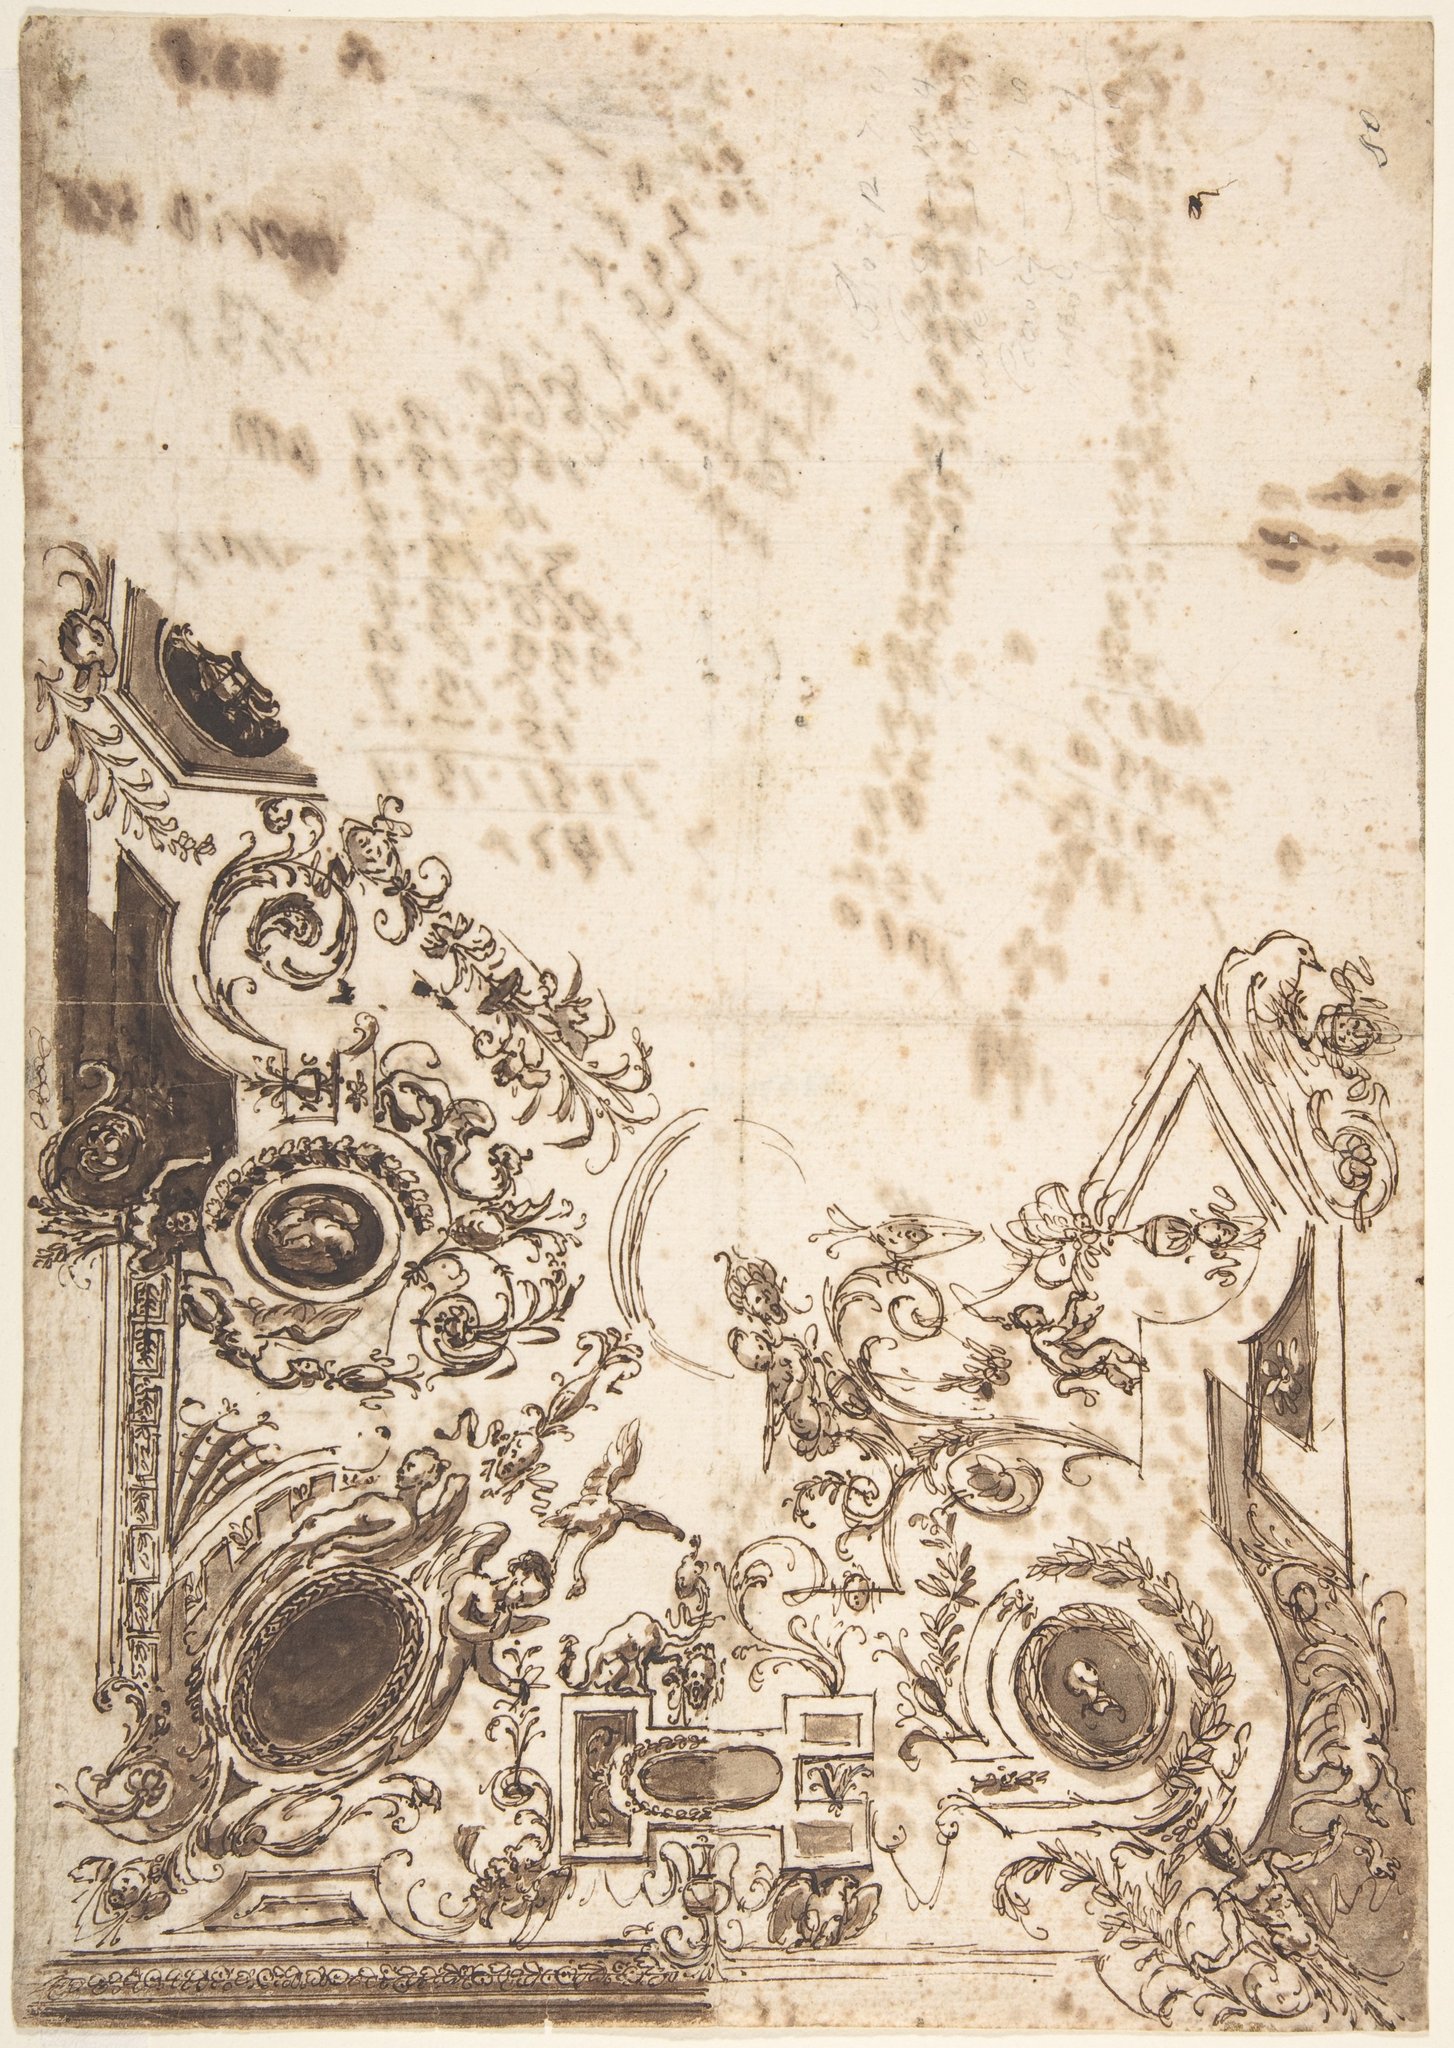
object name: drawing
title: Design for a Ceiling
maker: anonymous, italian, 18th century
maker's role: artist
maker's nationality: italian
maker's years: 1700-1800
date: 1701-1800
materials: ink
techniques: pen, wash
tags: architecture,ceilings